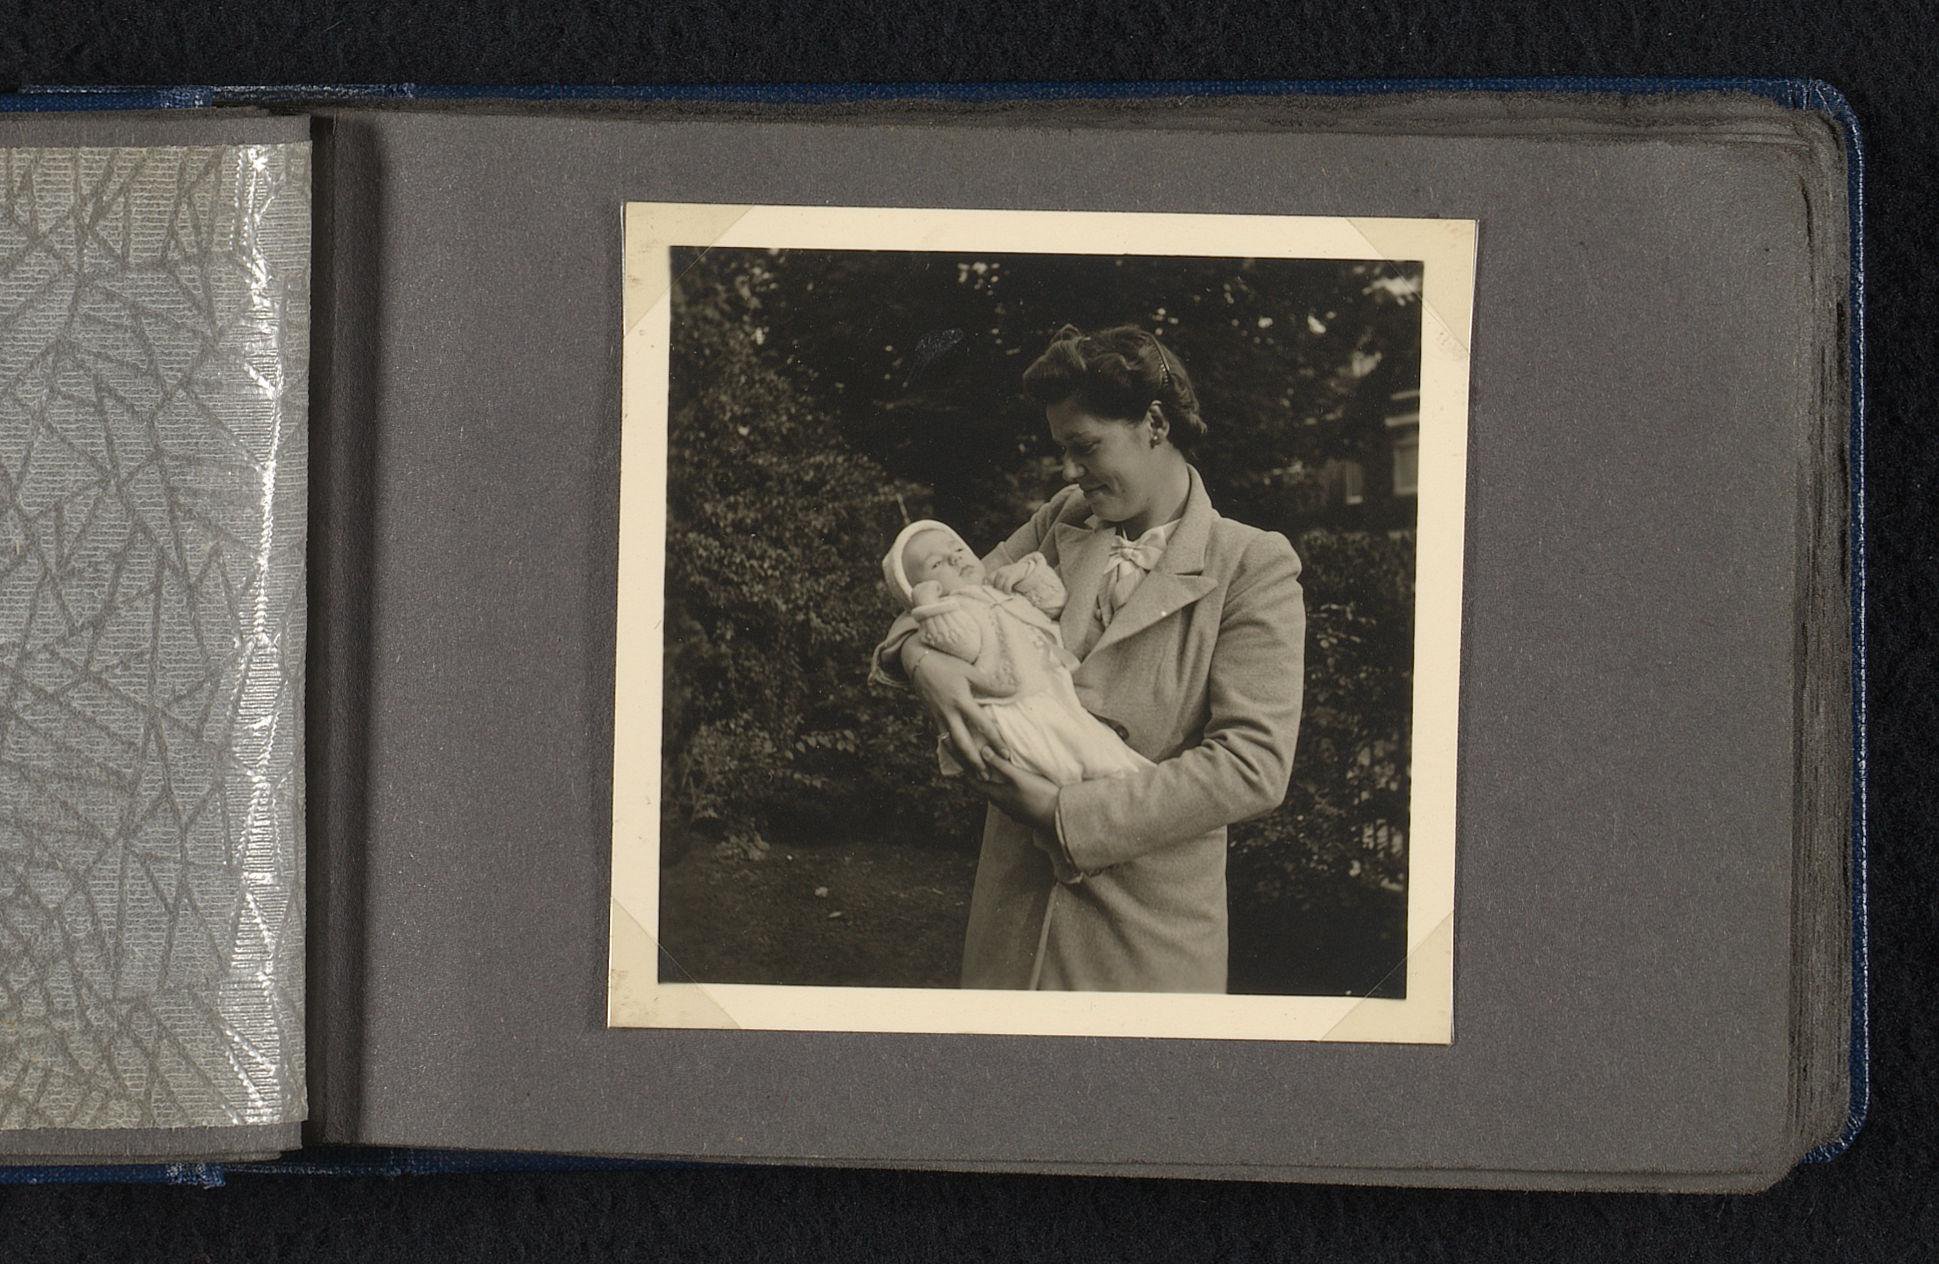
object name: album leaf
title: Maria Louise van den Berg-Halbertsma doet pasgeboren zoon Norbert in haar armen in een tuin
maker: norbert peter van den berg (1941-)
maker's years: 1941-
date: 1941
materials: paper, cardboard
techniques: gelatin silver print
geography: netherlands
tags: amsterdam, norbert peter van den berg (1941-), rotterdam, maria louise van den berg-halbertsma, adult woman, garden, infant, baby